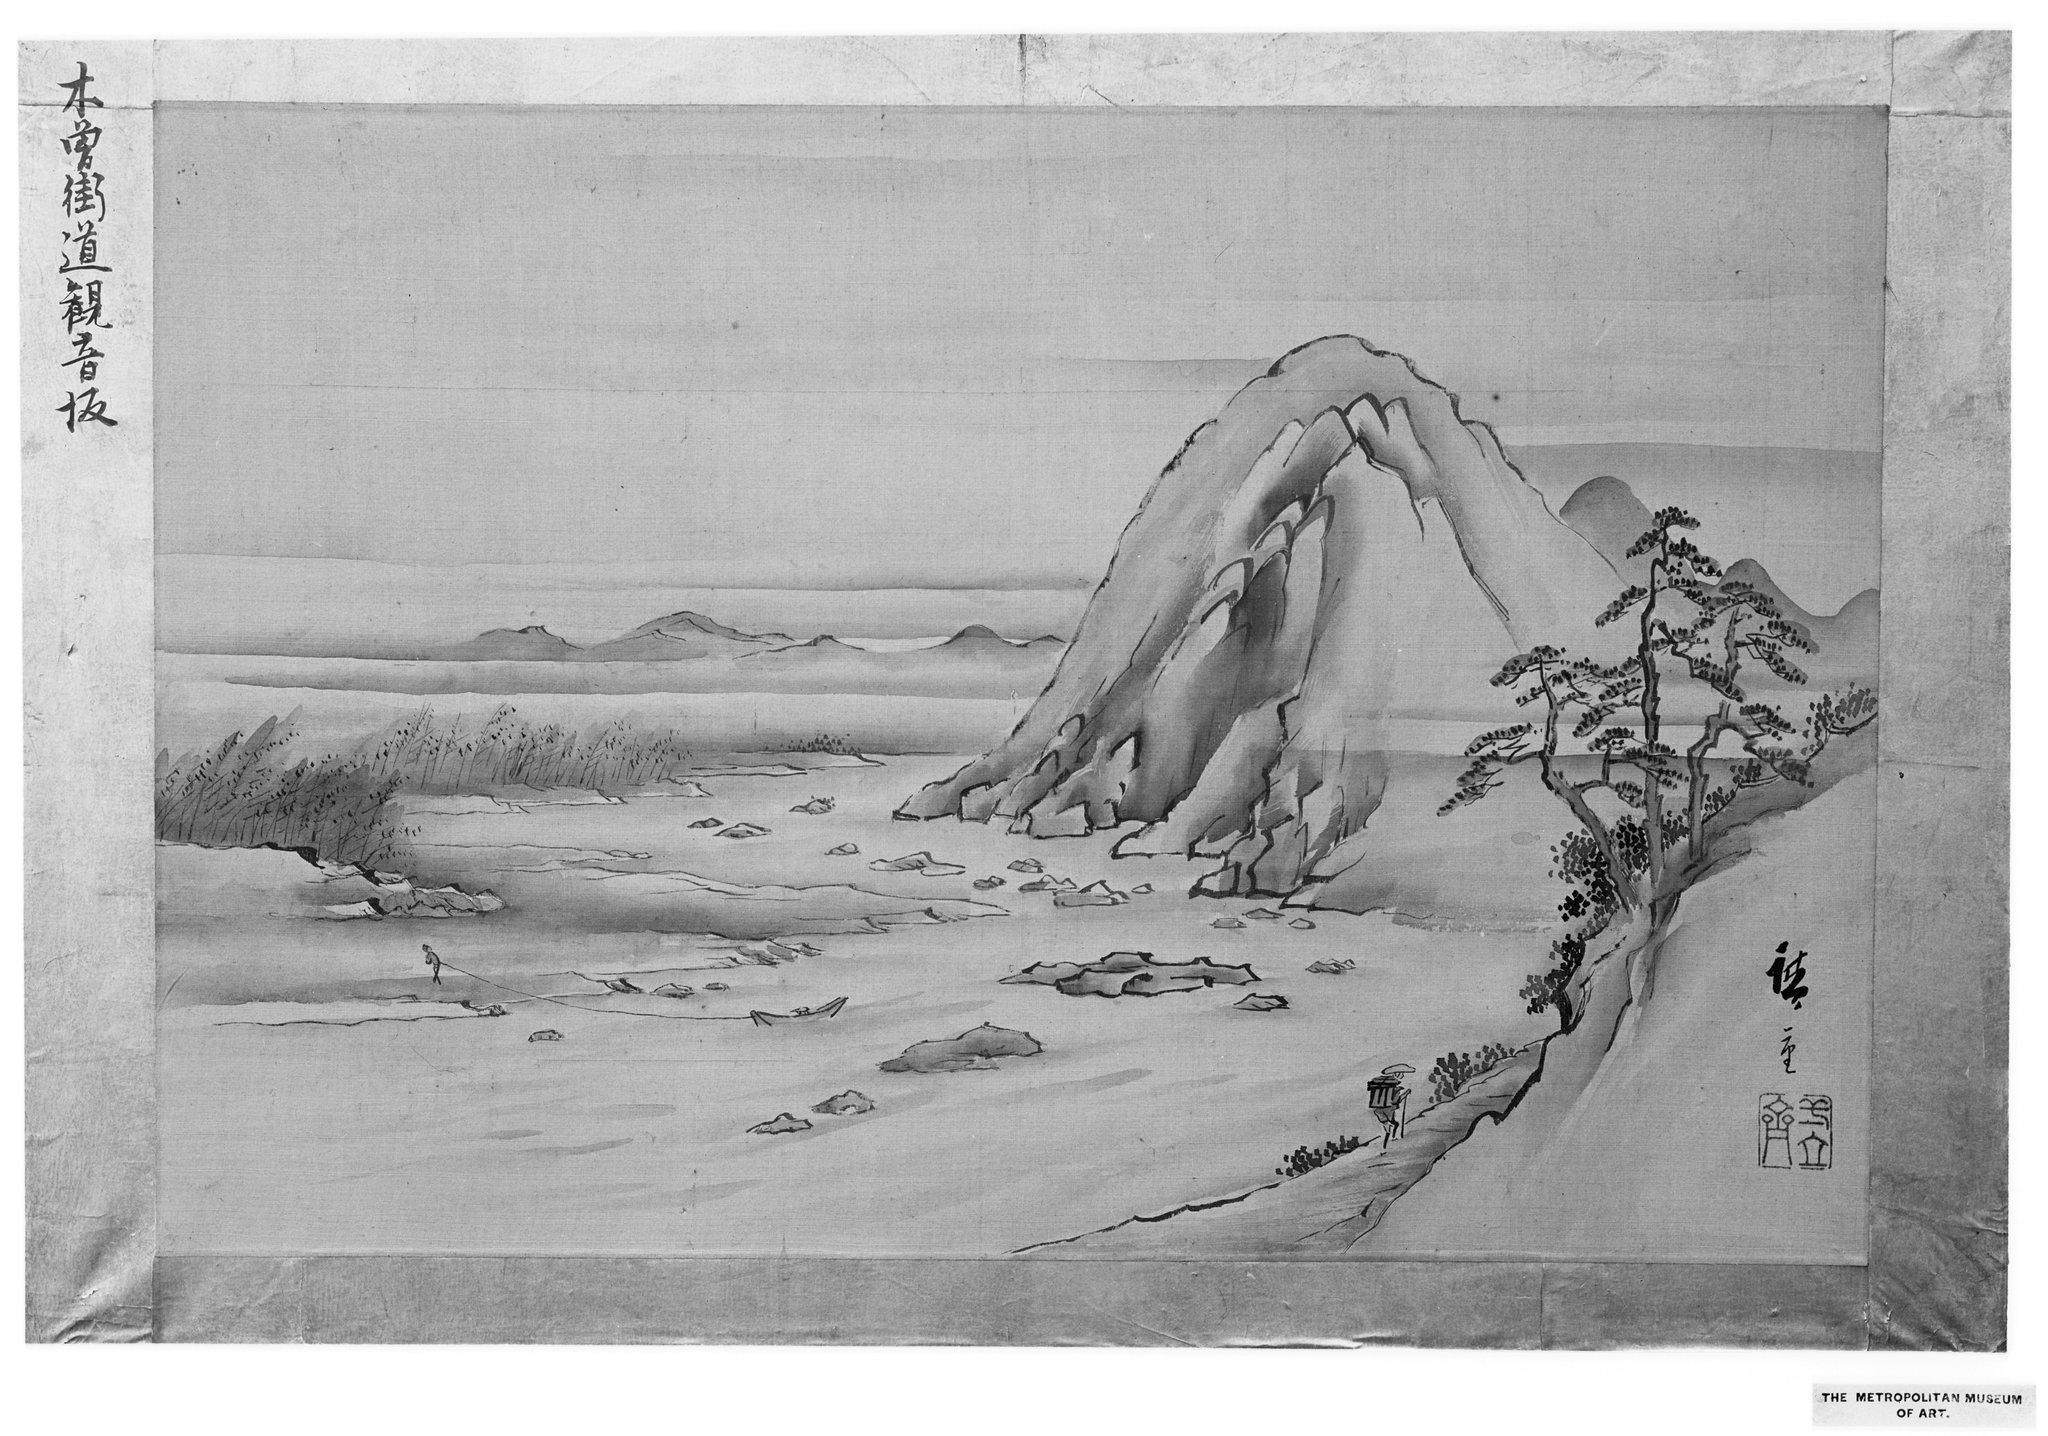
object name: painting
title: Kannon Slope of the Kiso Highway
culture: japanese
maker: utagawa hiroshige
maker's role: artist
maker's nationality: japanese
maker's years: 1797-1858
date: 1801-1900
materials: ink, silk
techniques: painting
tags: mountains,landscapes